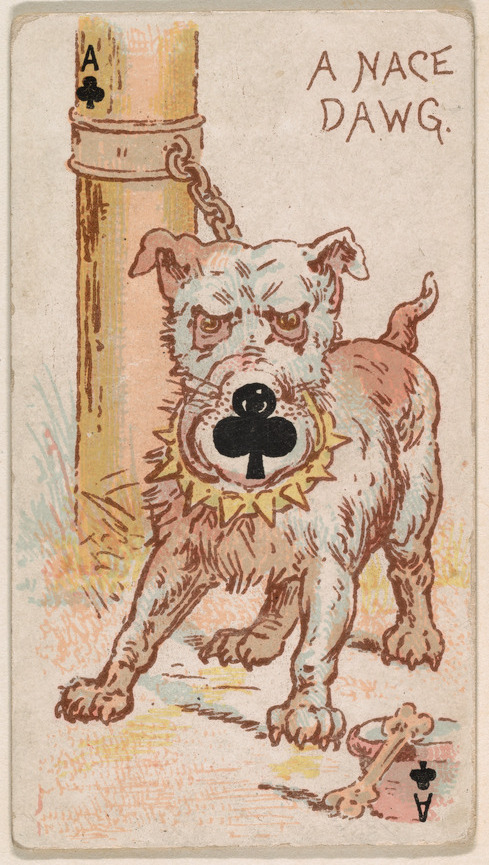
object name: print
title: Ace of Clubs, A Nace Dawg, from Harlequin Cards, 2nd Series (N220) issued by Kinney Bros.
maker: kinney brothers tobacco company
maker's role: publisher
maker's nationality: american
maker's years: 1869-2011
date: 1889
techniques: color lithograph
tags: playing cards,dogs